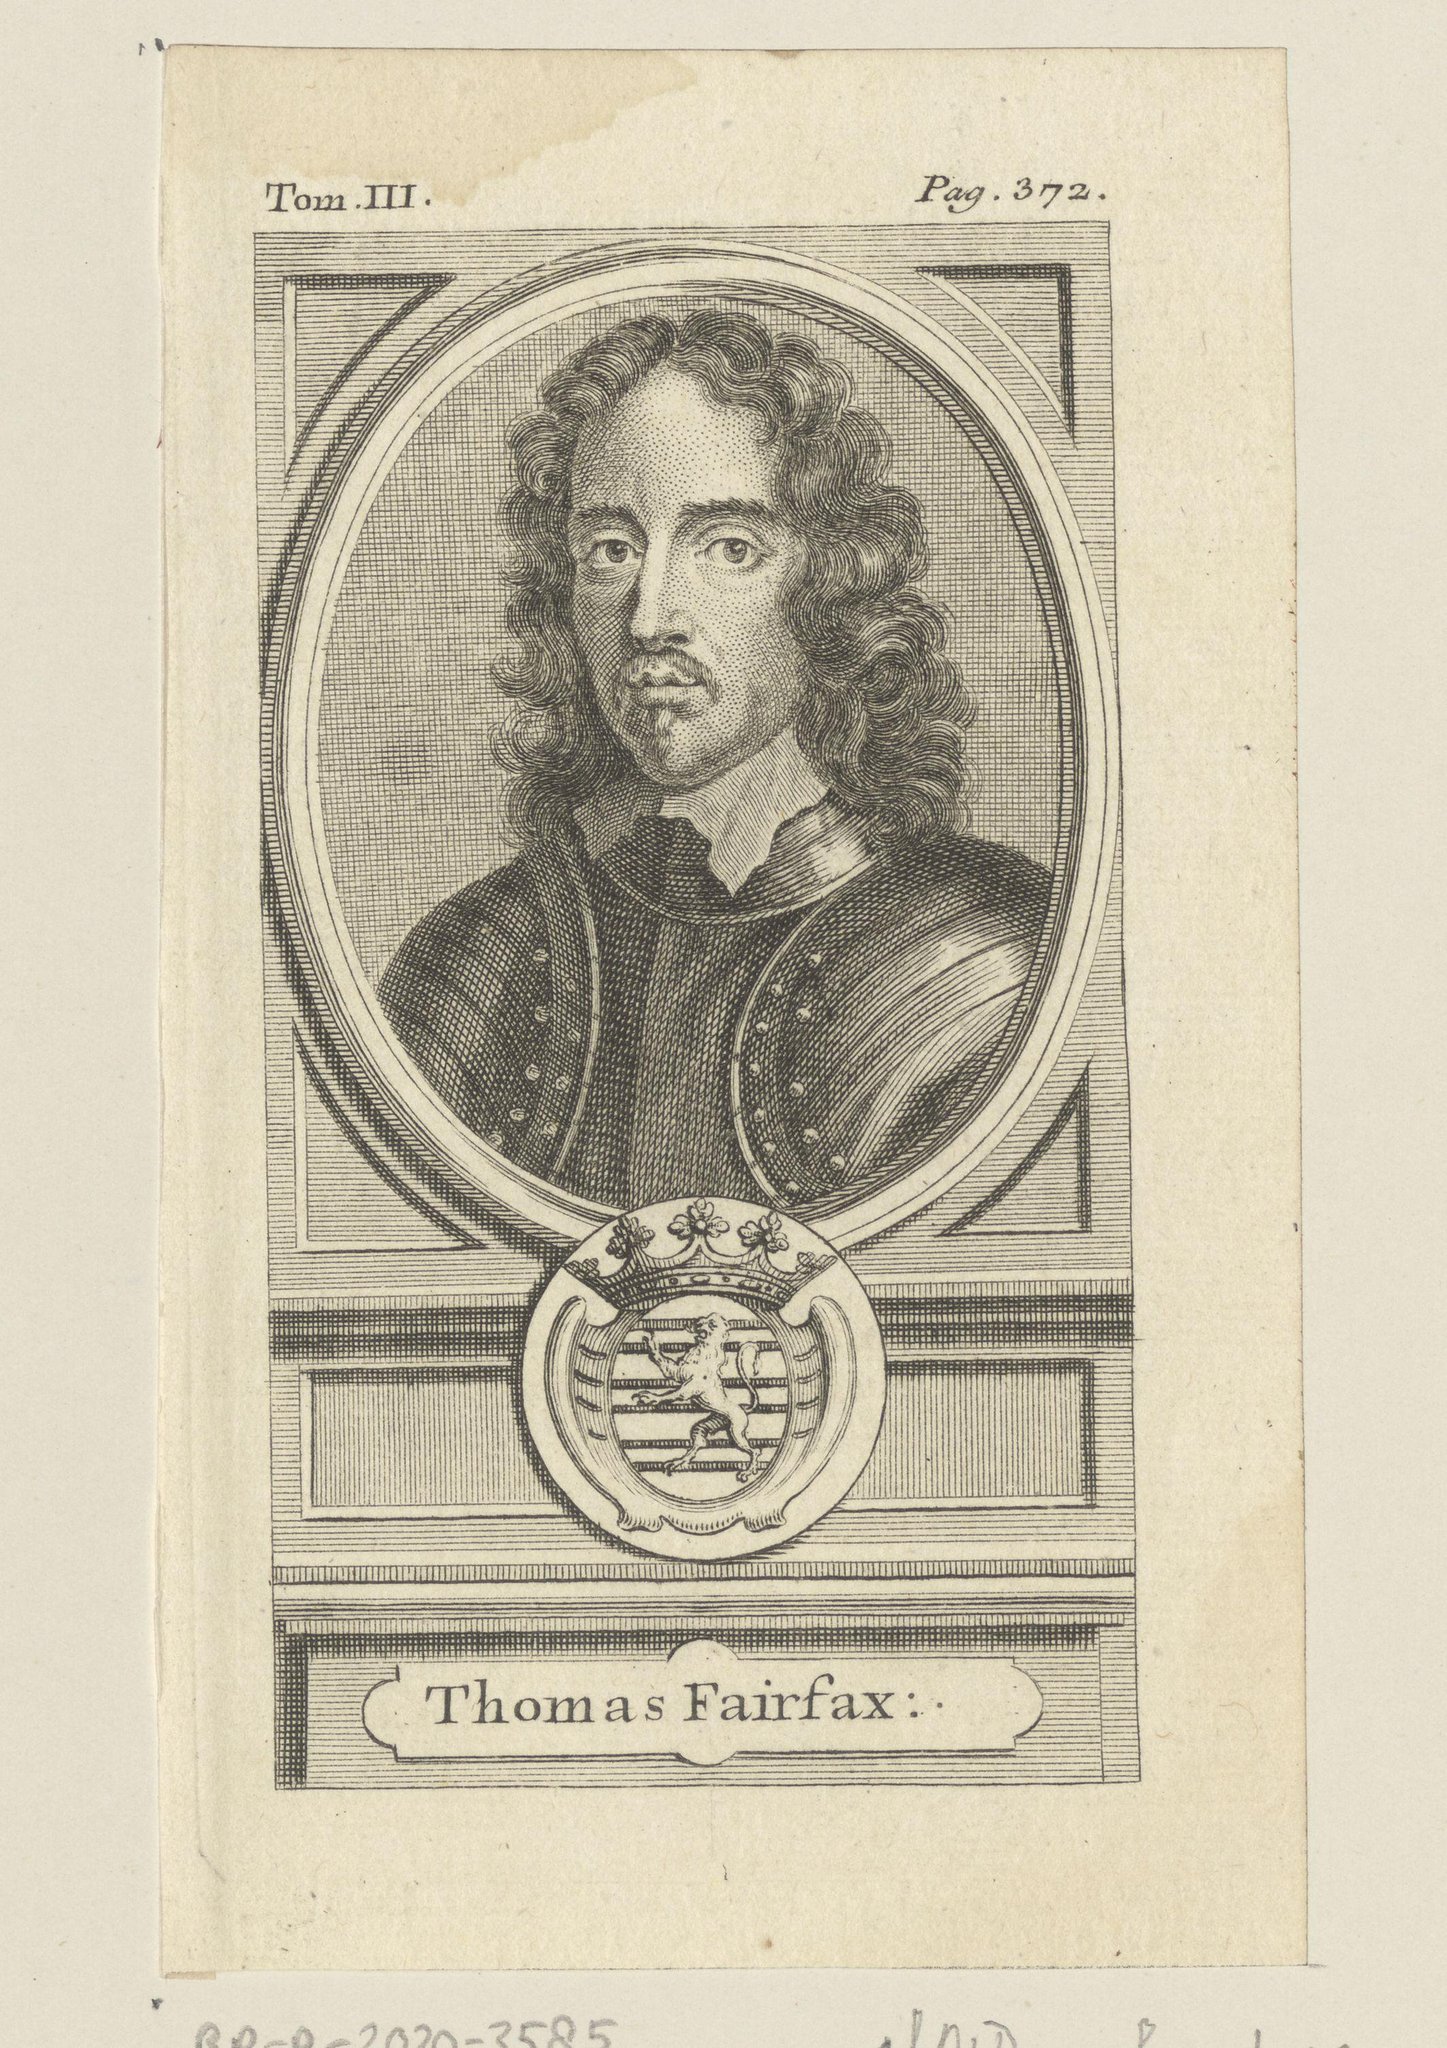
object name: book illustration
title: Portret van Thomas Fairfax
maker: Anonymous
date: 1650-1750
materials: paper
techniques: etching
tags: commander-in-chief, general, marshal, historical persons, armorial bearing, heraldry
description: Linksboven: Tom. III. Rechtsboven: Pag. 372.